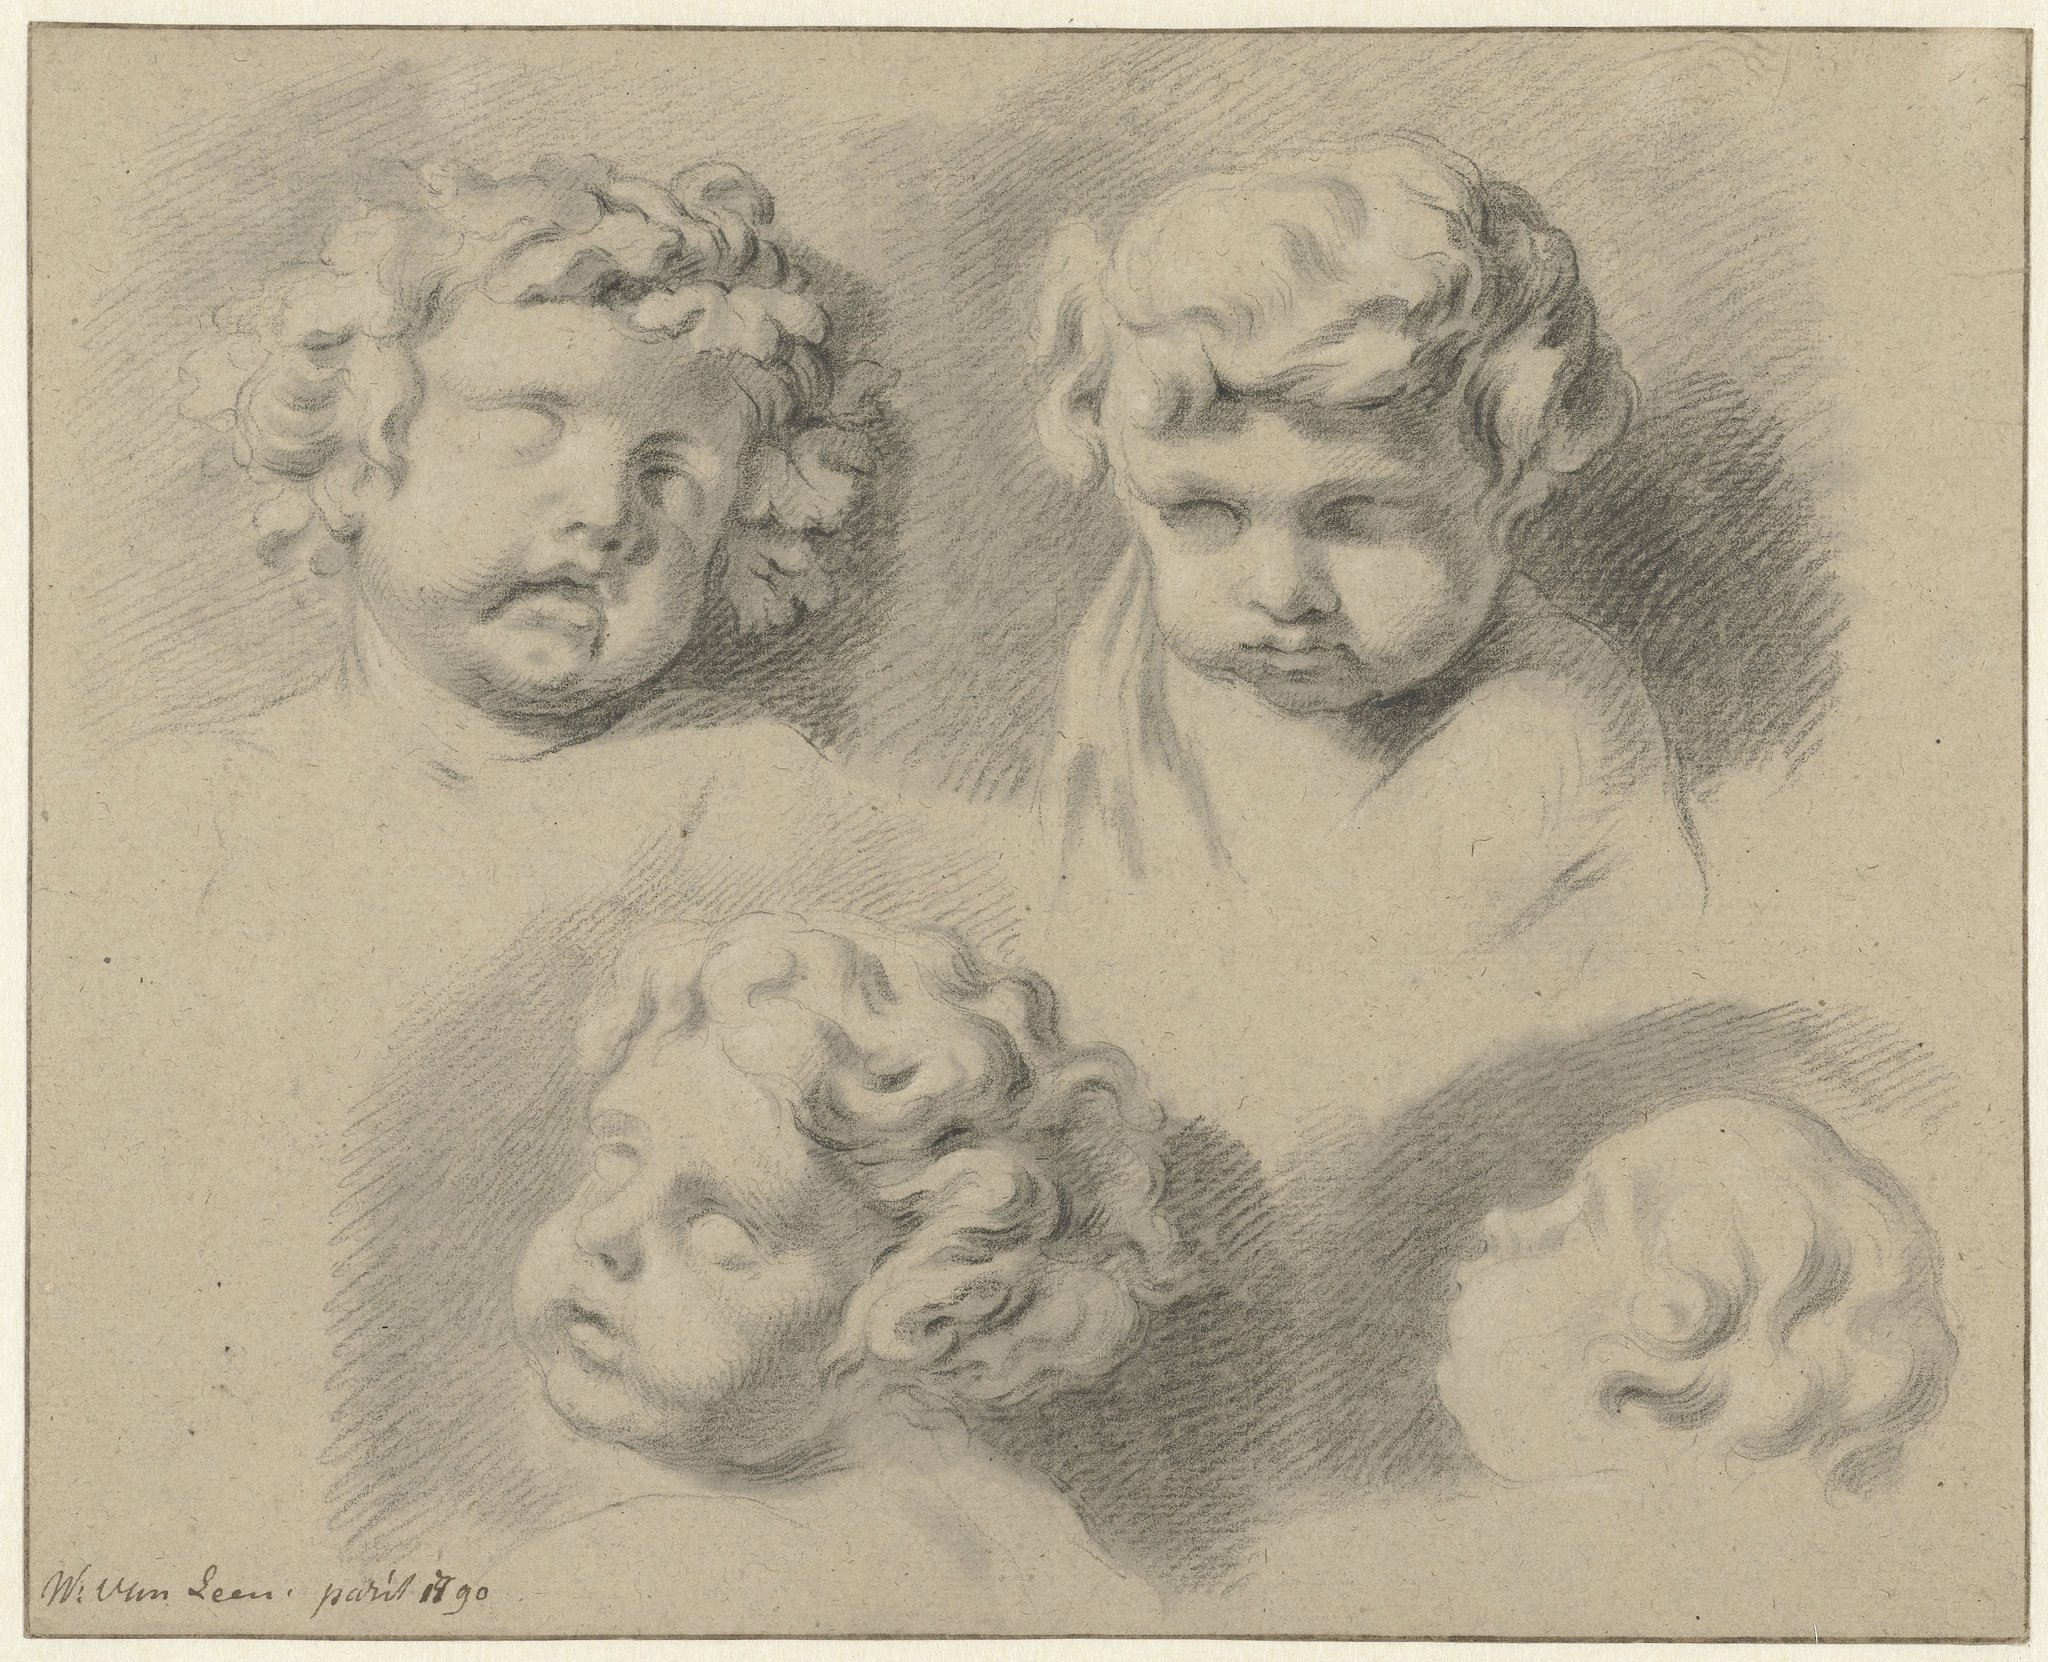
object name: drawing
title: Vier kinderkopjes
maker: willem van leen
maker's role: draughtsman, print maker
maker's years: 1753-1825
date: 1790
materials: chalk, paper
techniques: brush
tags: child, piece of sculpture, reproduction of a piece of sculpture